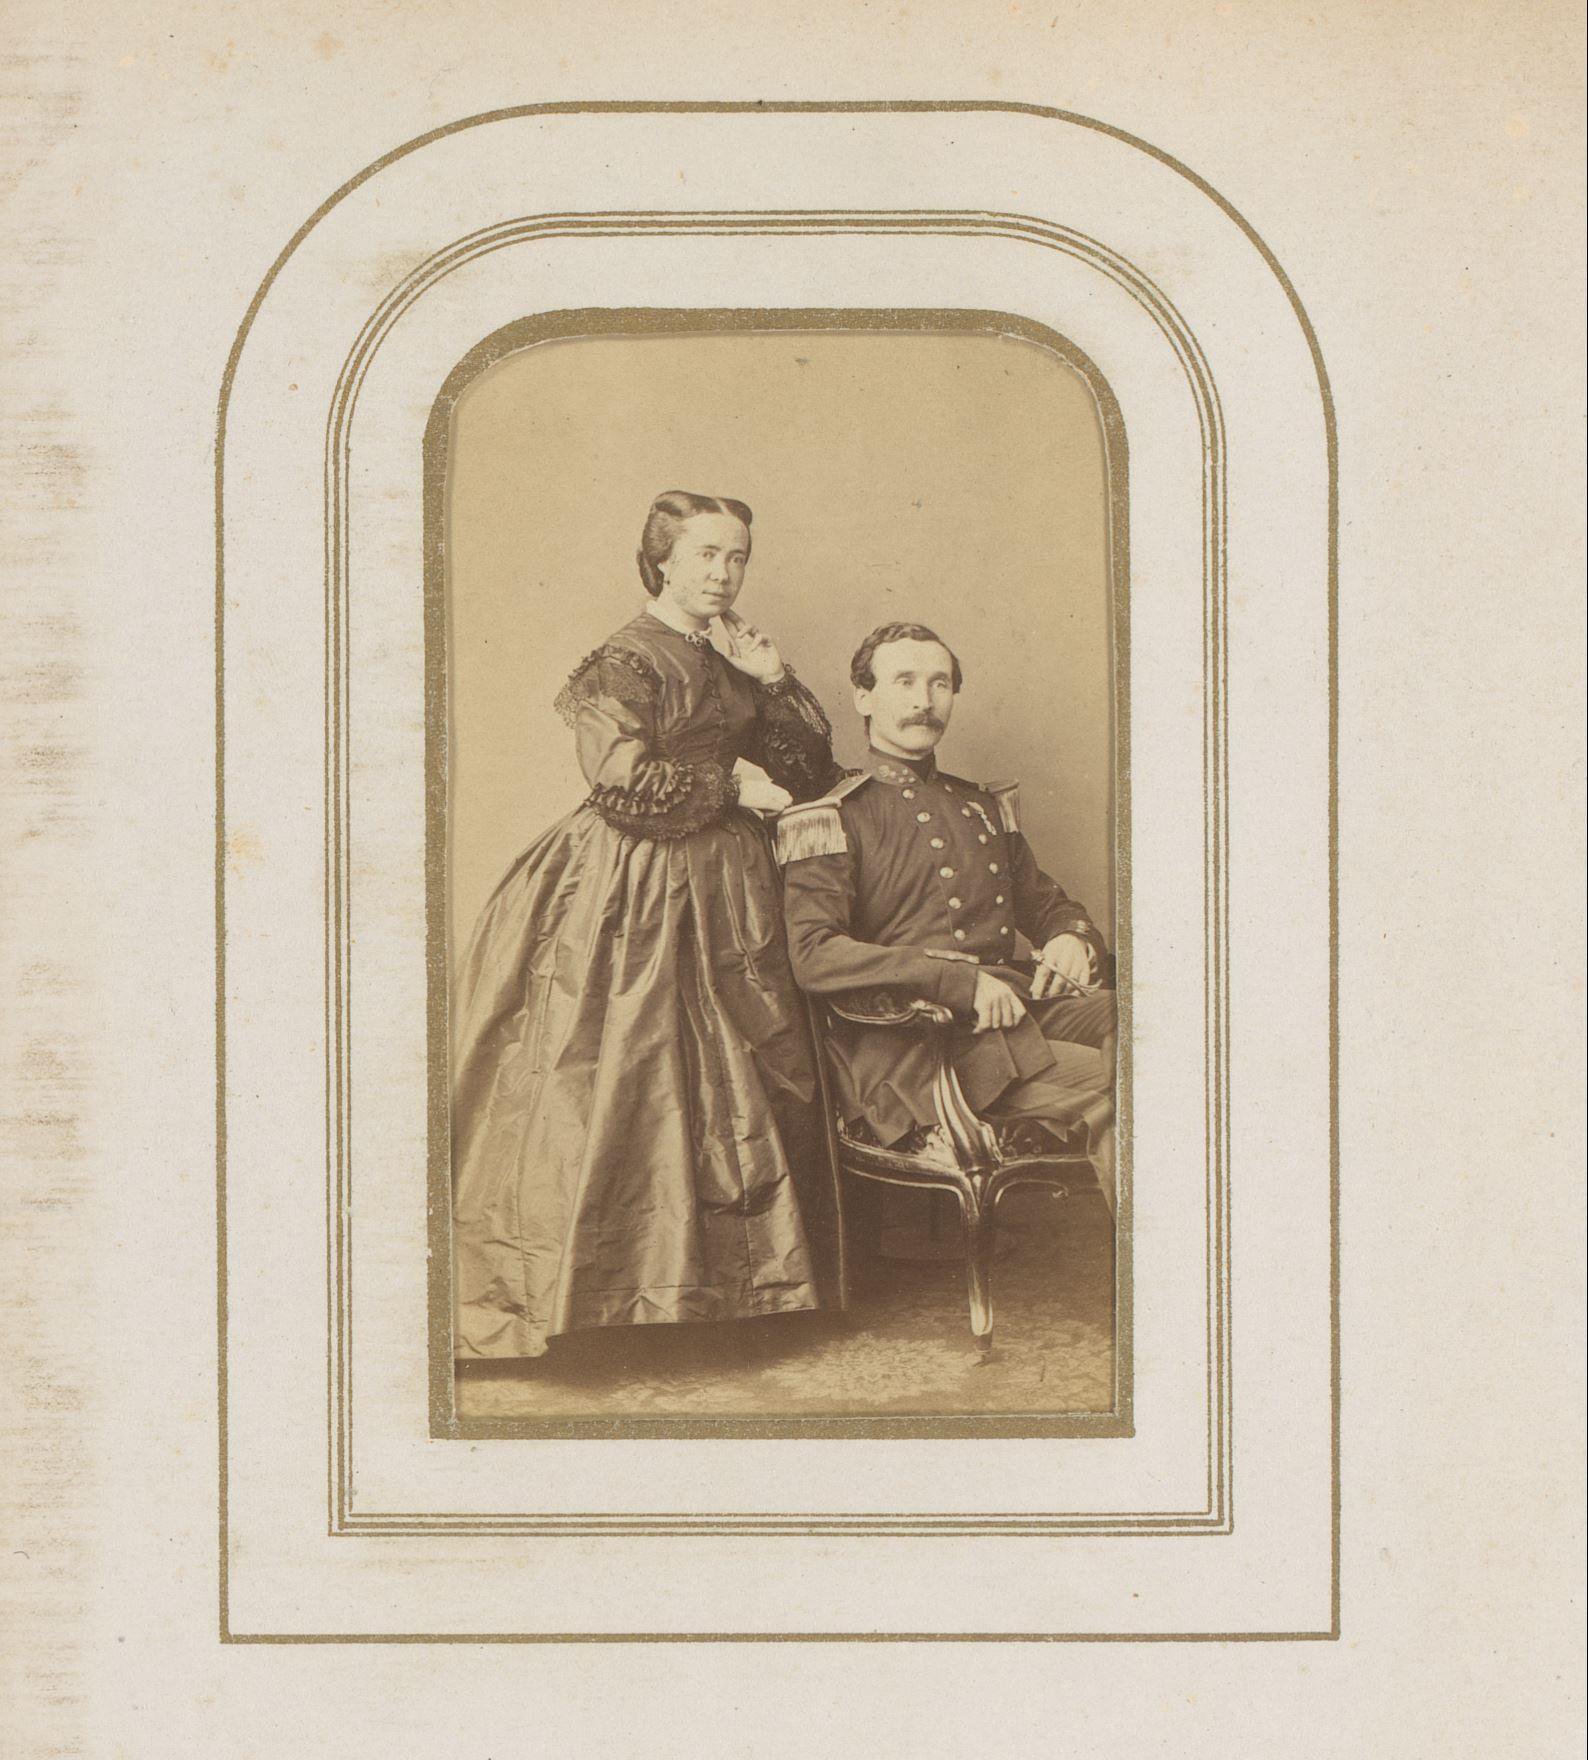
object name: album leaf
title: Portret van een echtpaar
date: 1860-1890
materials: cardboard, photographic support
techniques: albumen print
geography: brussels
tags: couple of lovers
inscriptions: annotation: ‘Souvenir d'affection/ [Mathilde Baltic]’, inscription: ‘Atelier de Photographie/ Billotte Frères/ 9, rue de la Reine/ près la Place de la Monnaie/ Bruxelles’